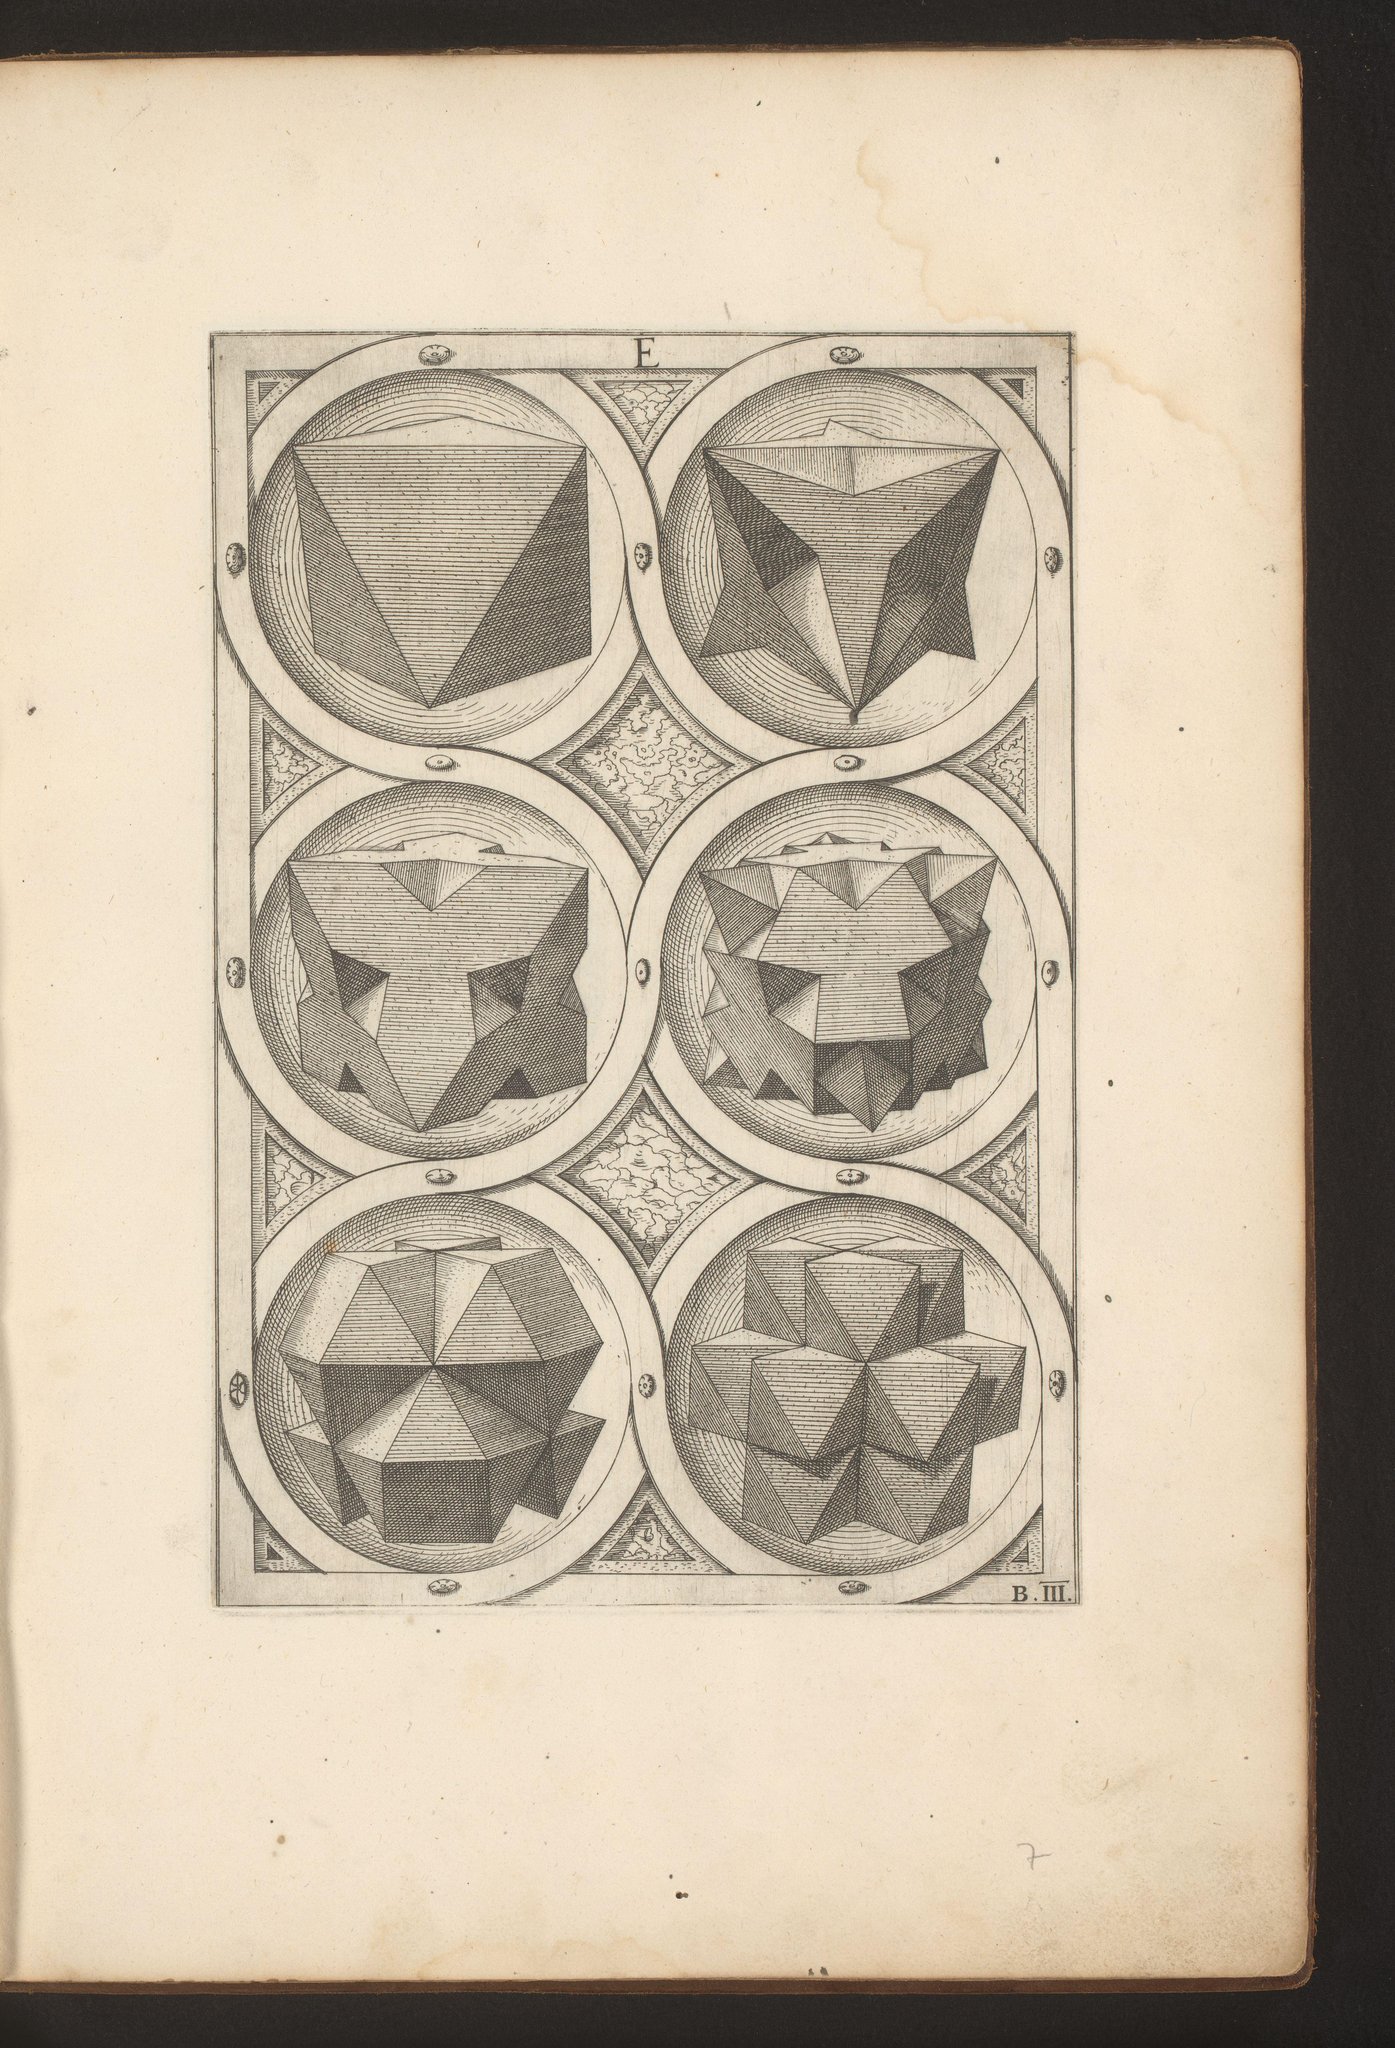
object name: page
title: Zes veelvlakken met een octaëder als uitgangspunt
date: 1568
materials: paper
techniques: etching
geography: nuremberg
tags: other polyhedrons, octahedron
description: De geometrische figuren (polyhedra) worden van boven naar beneden complexer. Rechtsonder genummerd: B.III. Deze prent maakt deel uit van een boek.